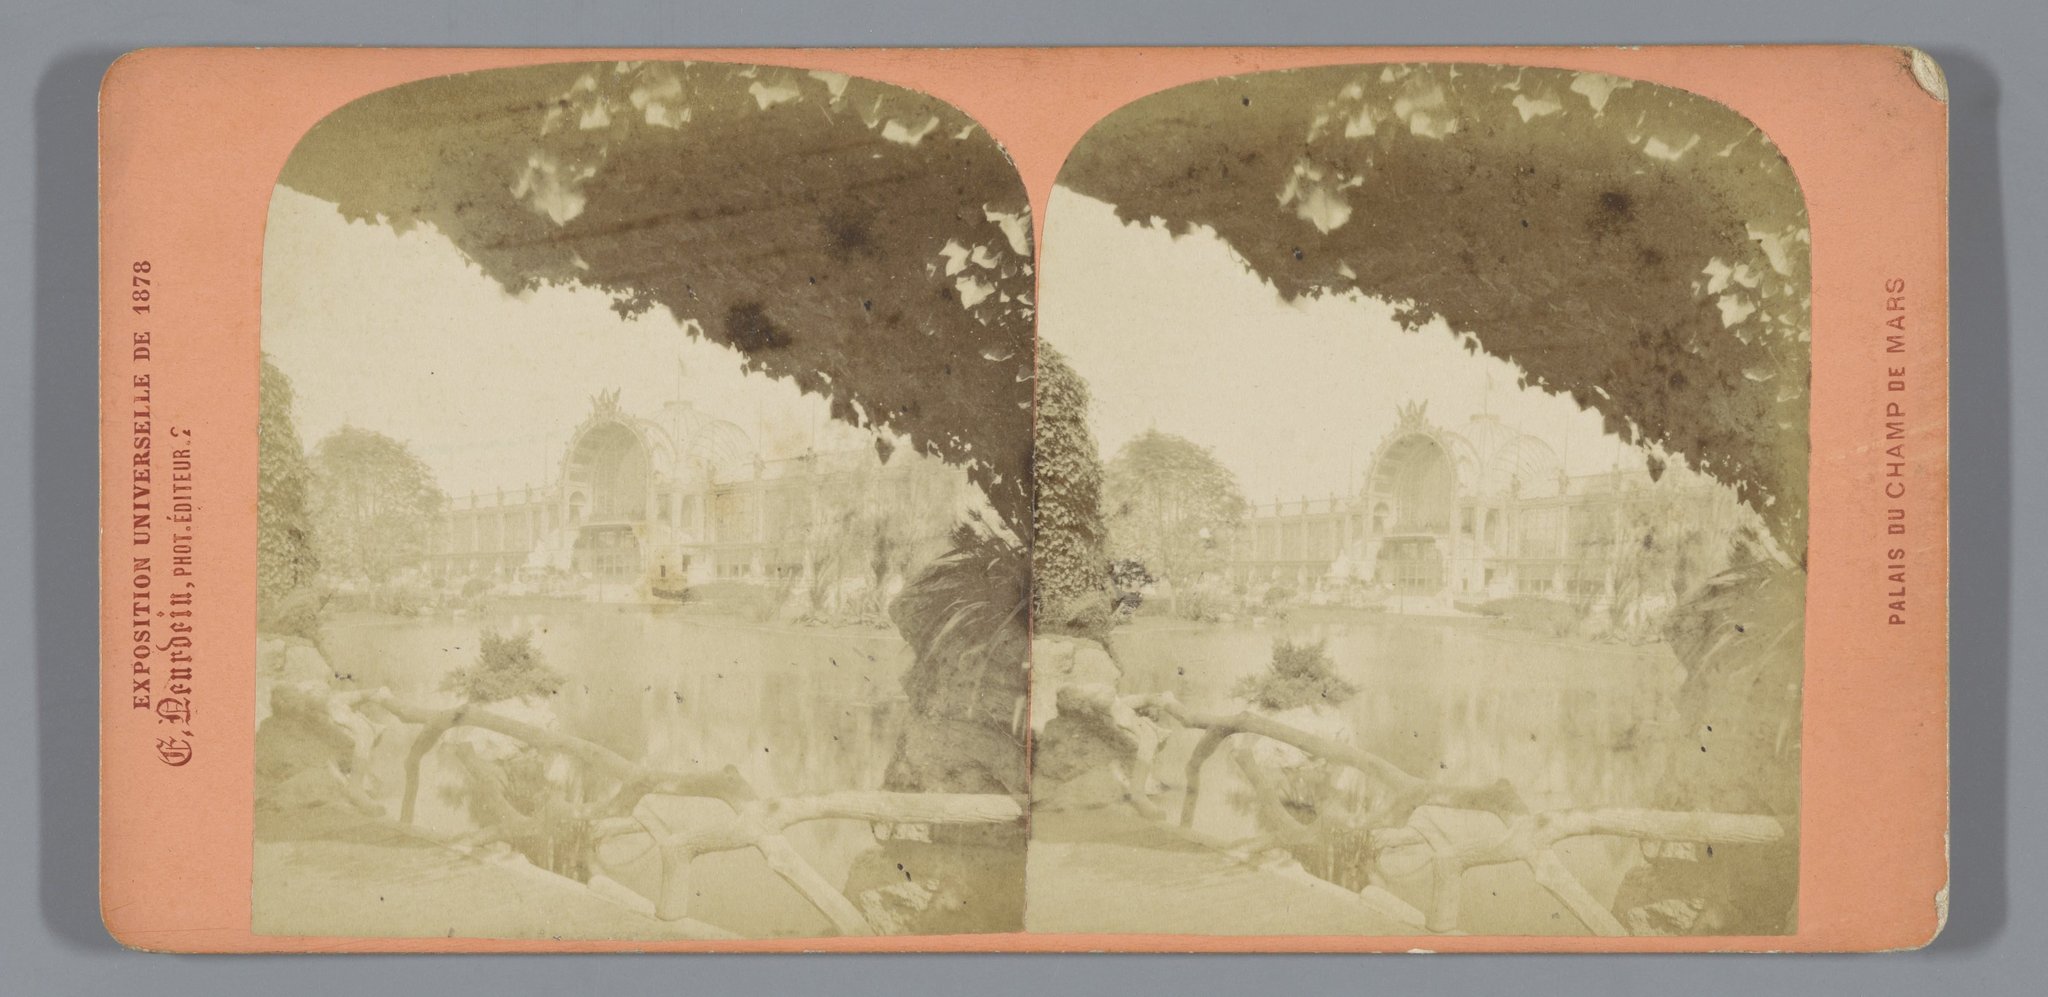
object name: stereograph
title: Palais du Champs de Mars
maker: étienne neurdein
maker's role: publisher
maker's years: 1832-1918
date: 1878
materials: cardboard, paper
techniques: albumen print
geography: paris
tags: world fair, world exhibition, palace, paris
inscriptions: inscription: ‘nt / 50ct / 40ct’